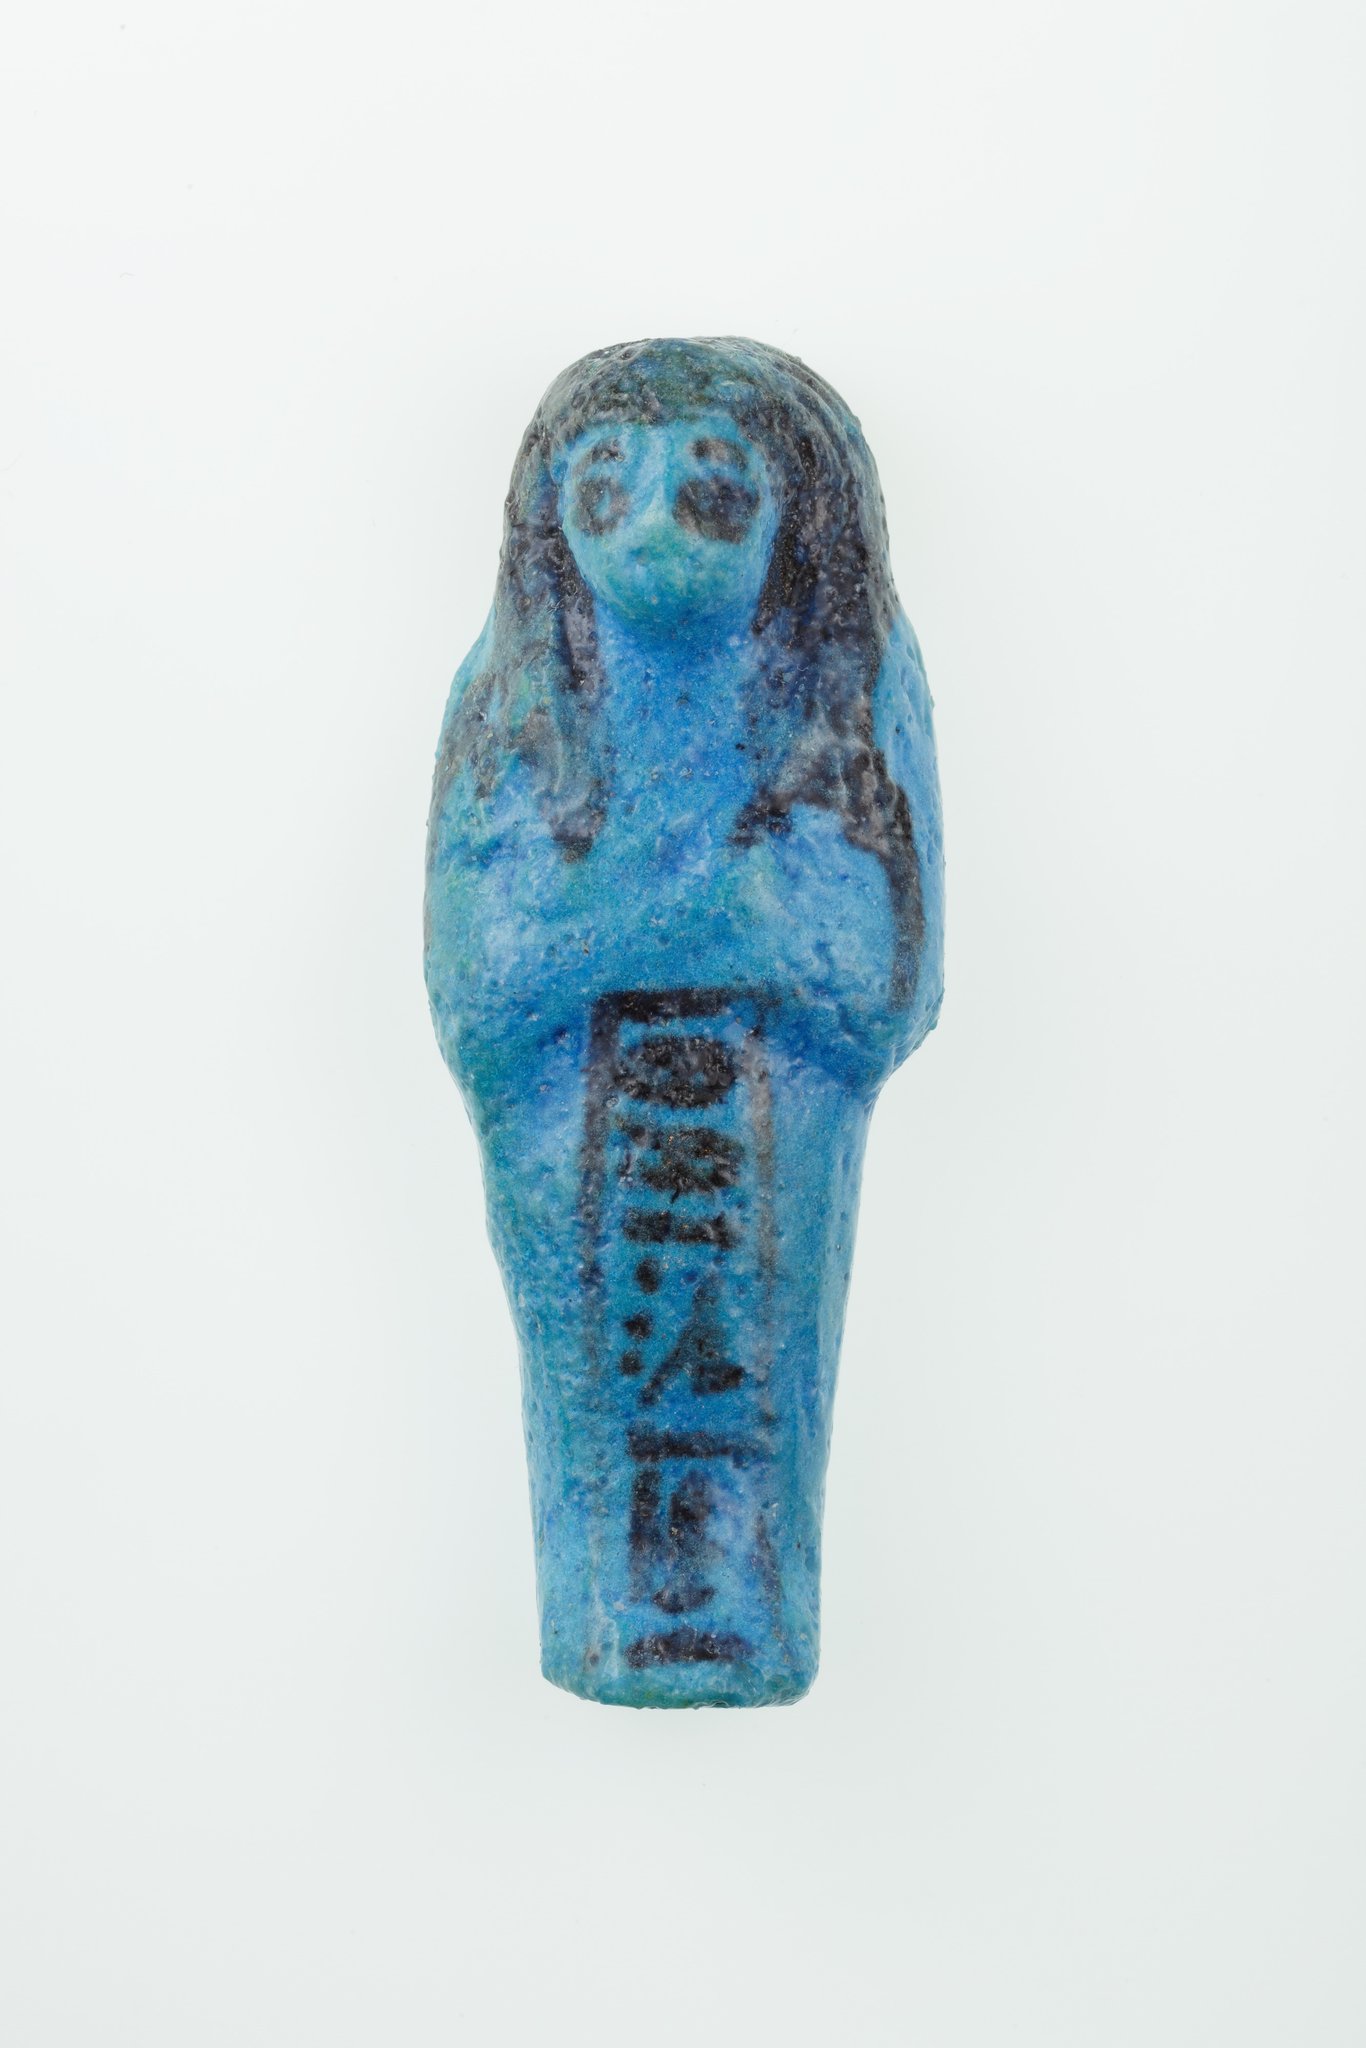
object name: shabti, worker, nauny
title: Worker Shabti of Nauny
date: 1050 BCE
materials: faience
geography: egypt